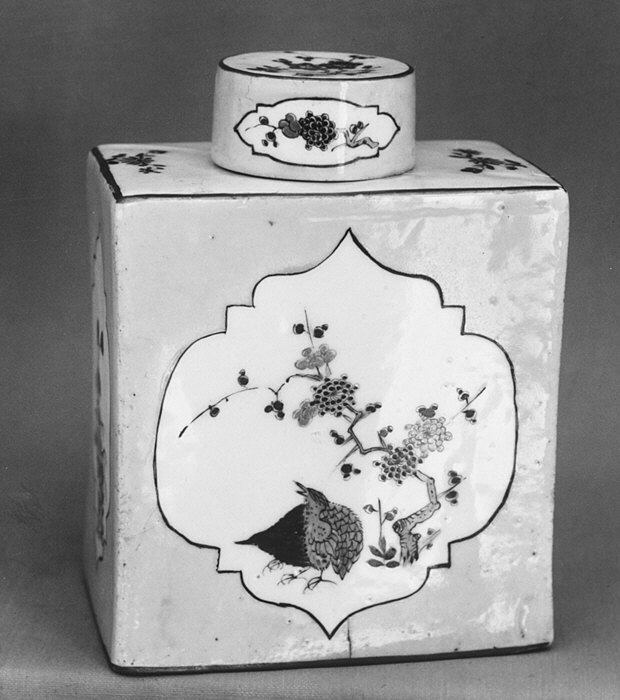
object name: tea caddy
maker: meissen manufactory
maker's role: manufactory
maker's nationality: german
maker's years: 1710-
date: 1735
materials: hard paste porcelain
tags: birds